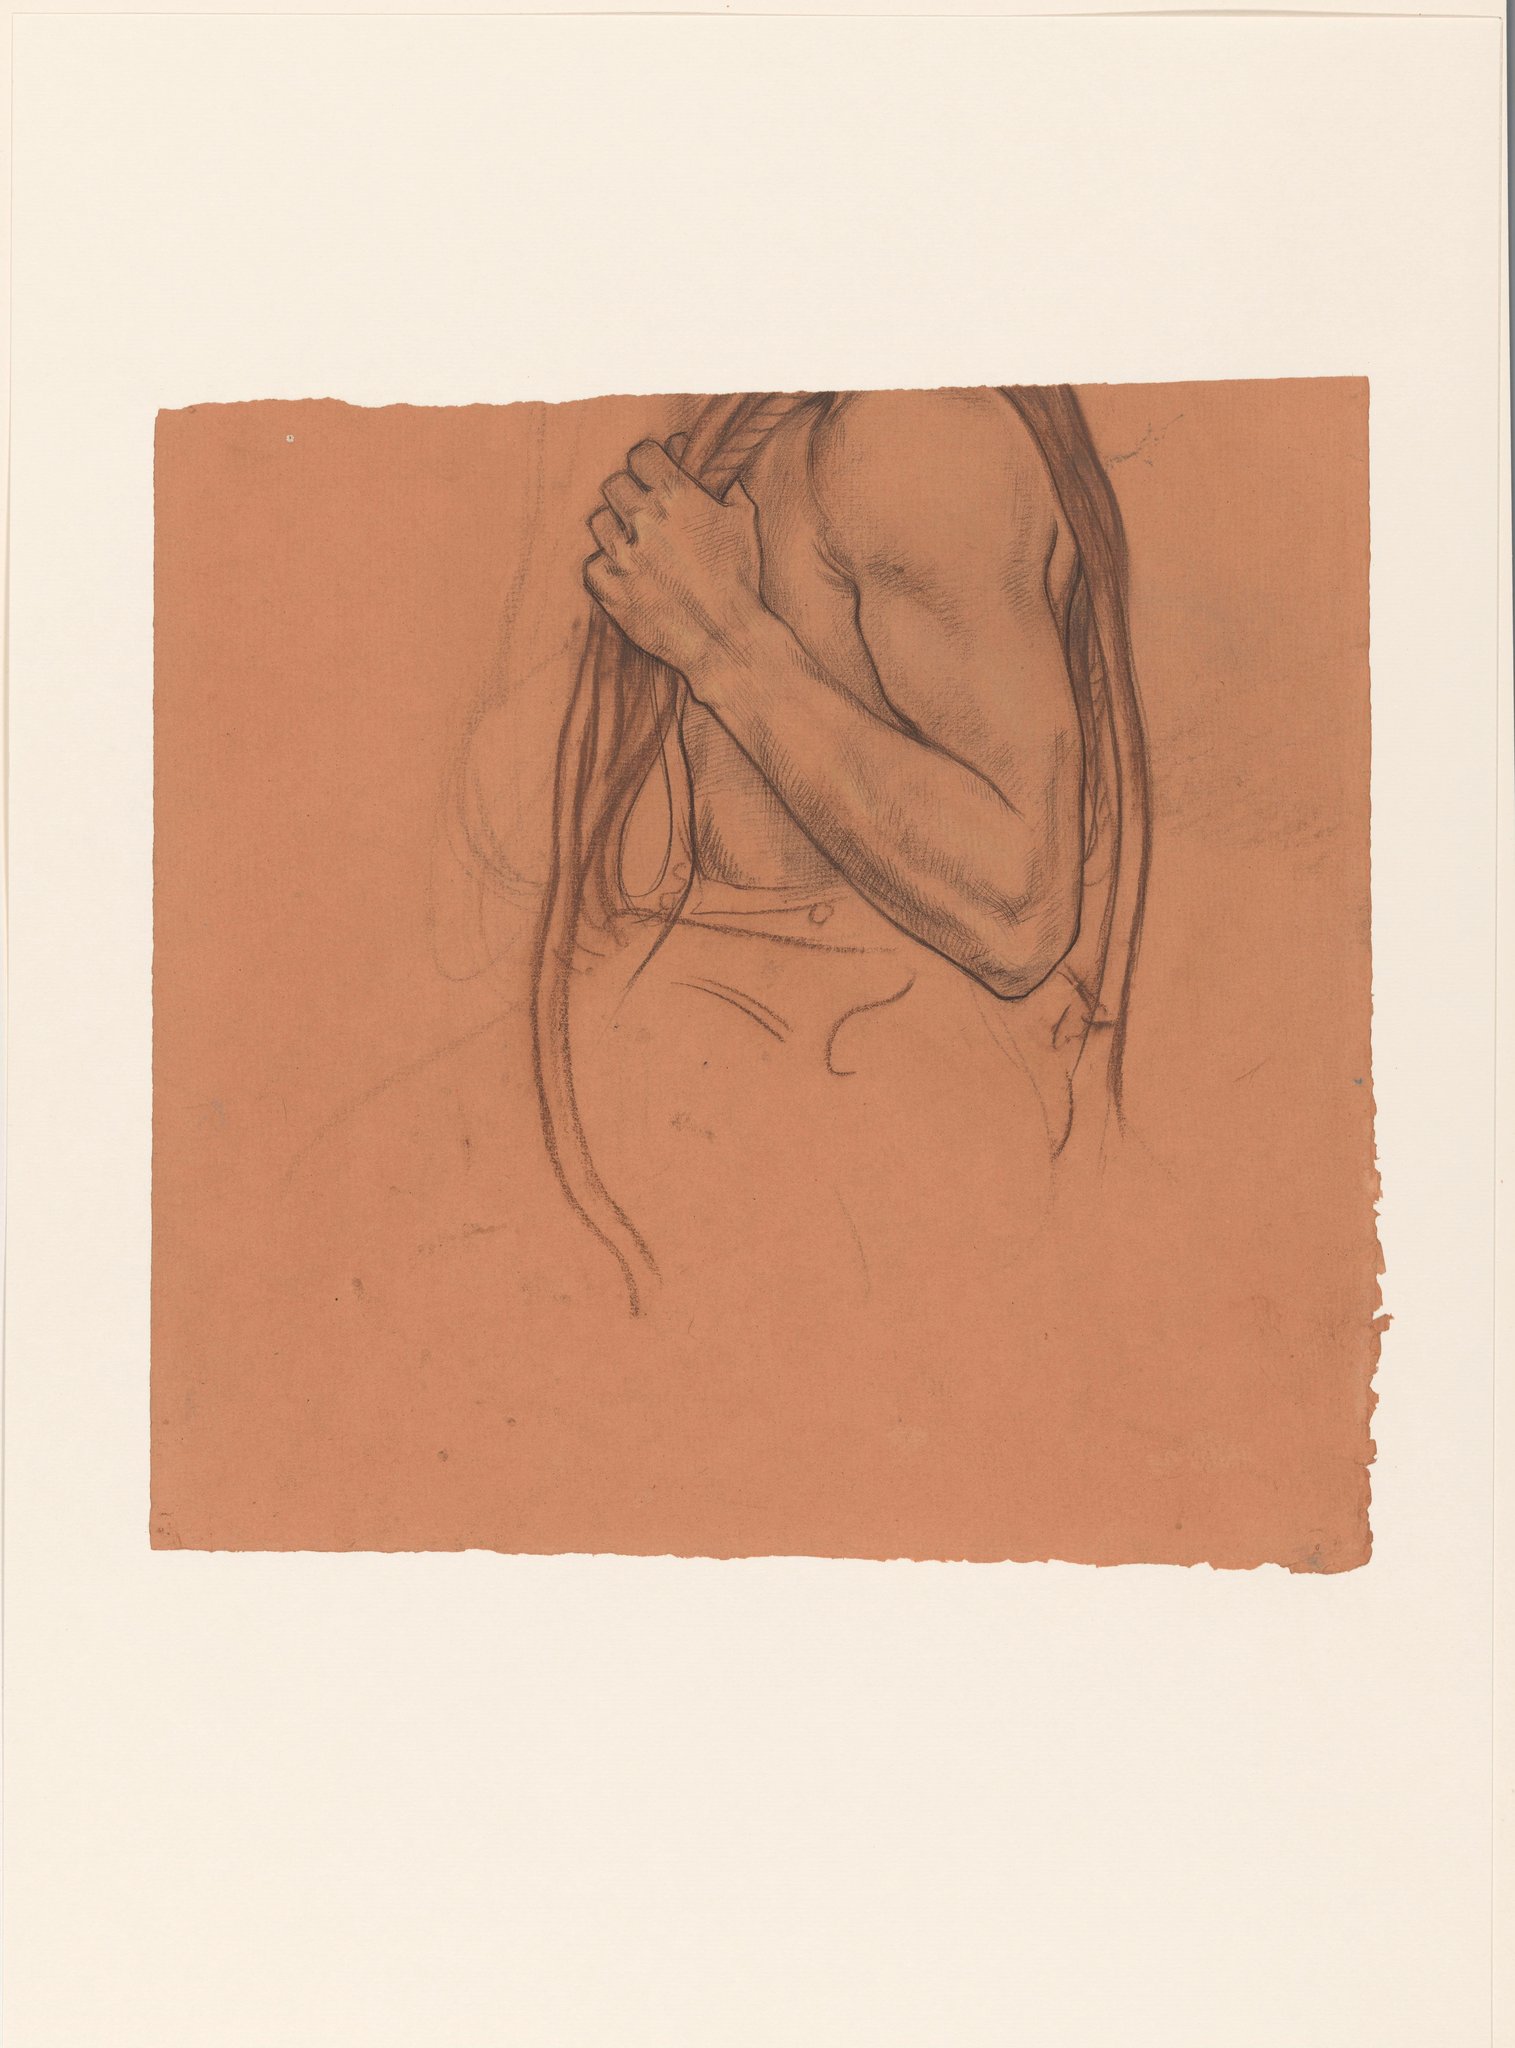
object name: drawing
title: Bovenlichaam van een man met touw over zijn schouder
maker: richard nicolaüs roland holst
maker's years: 1868-1938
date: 1878-1938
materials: chalk, paper